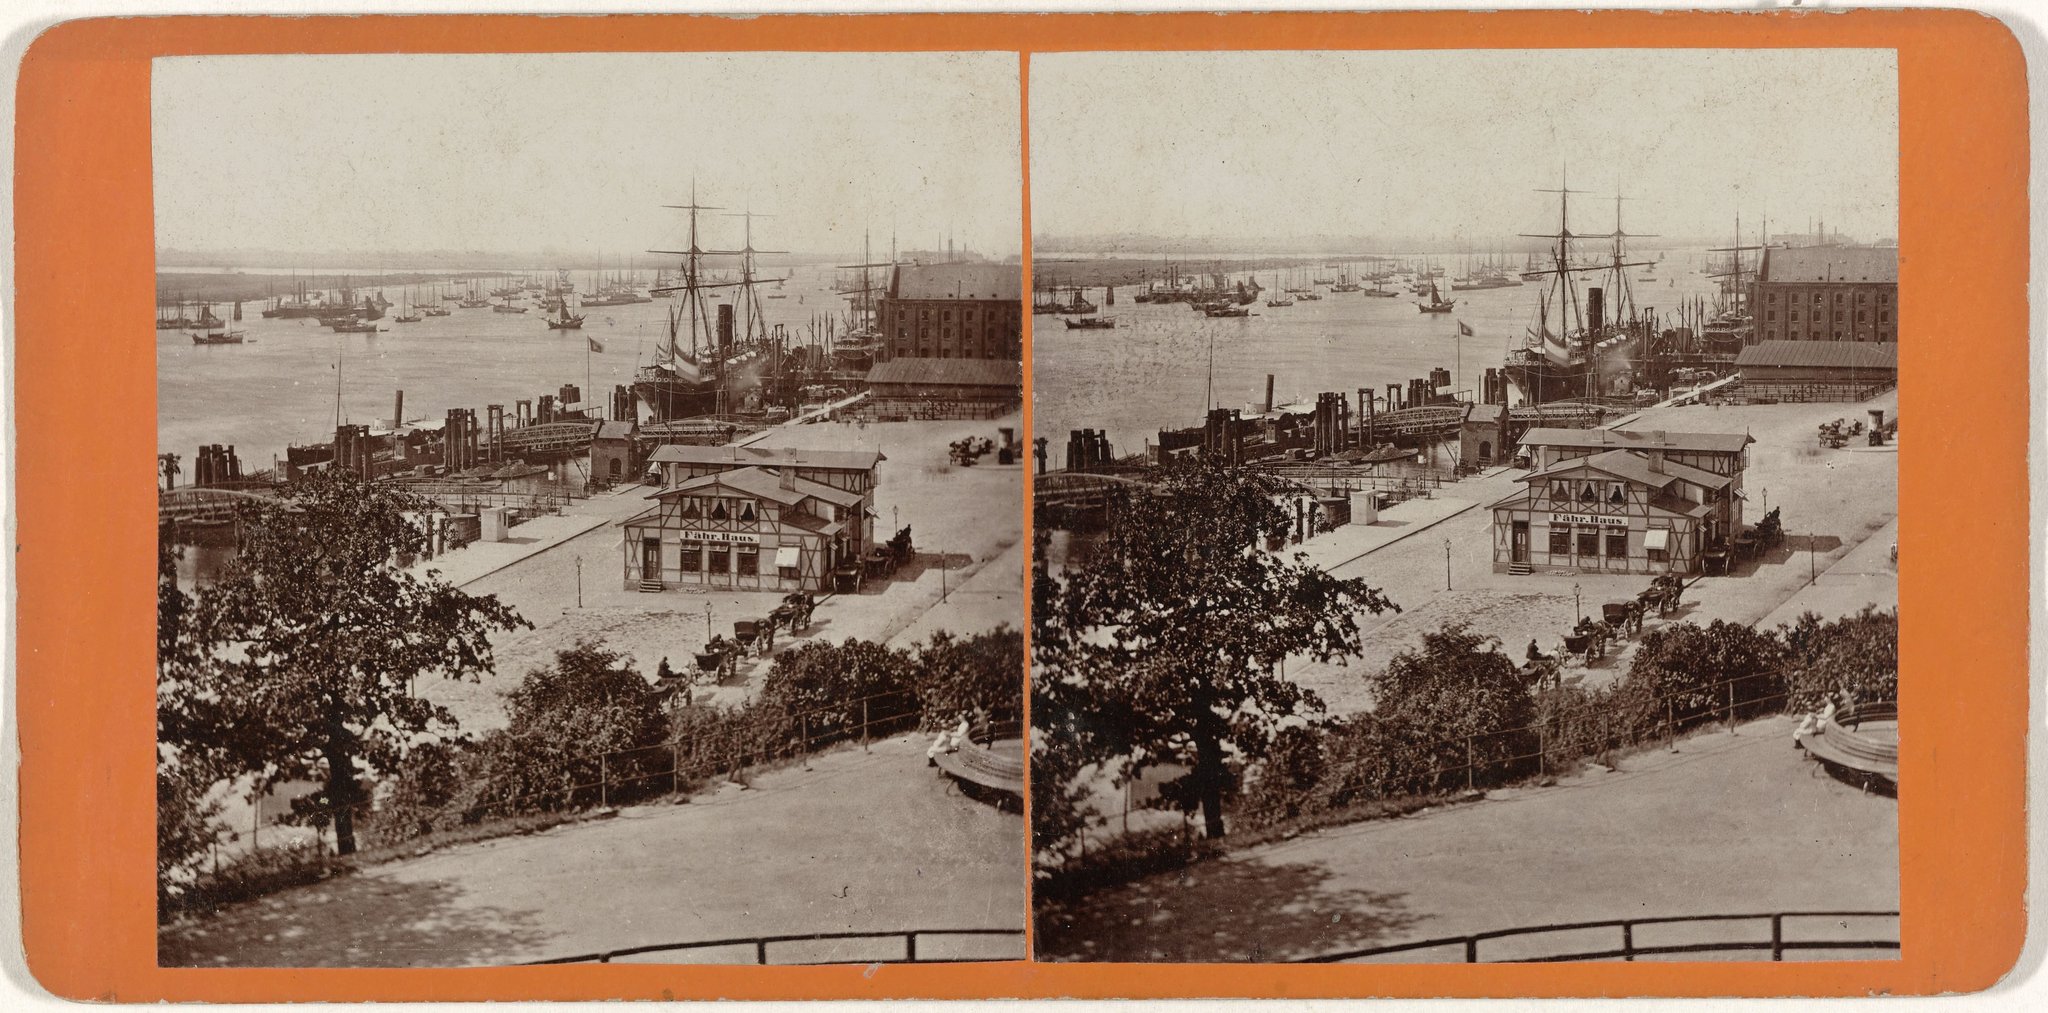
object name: stereograph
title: Gezicht op de oude haven van Hamburg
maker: Anonymous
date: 1873-1890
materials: cardboard, photographic support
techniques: gelatin silver print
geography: hamburg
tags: harbour, ships (in general) - cc - more than one ship, quay